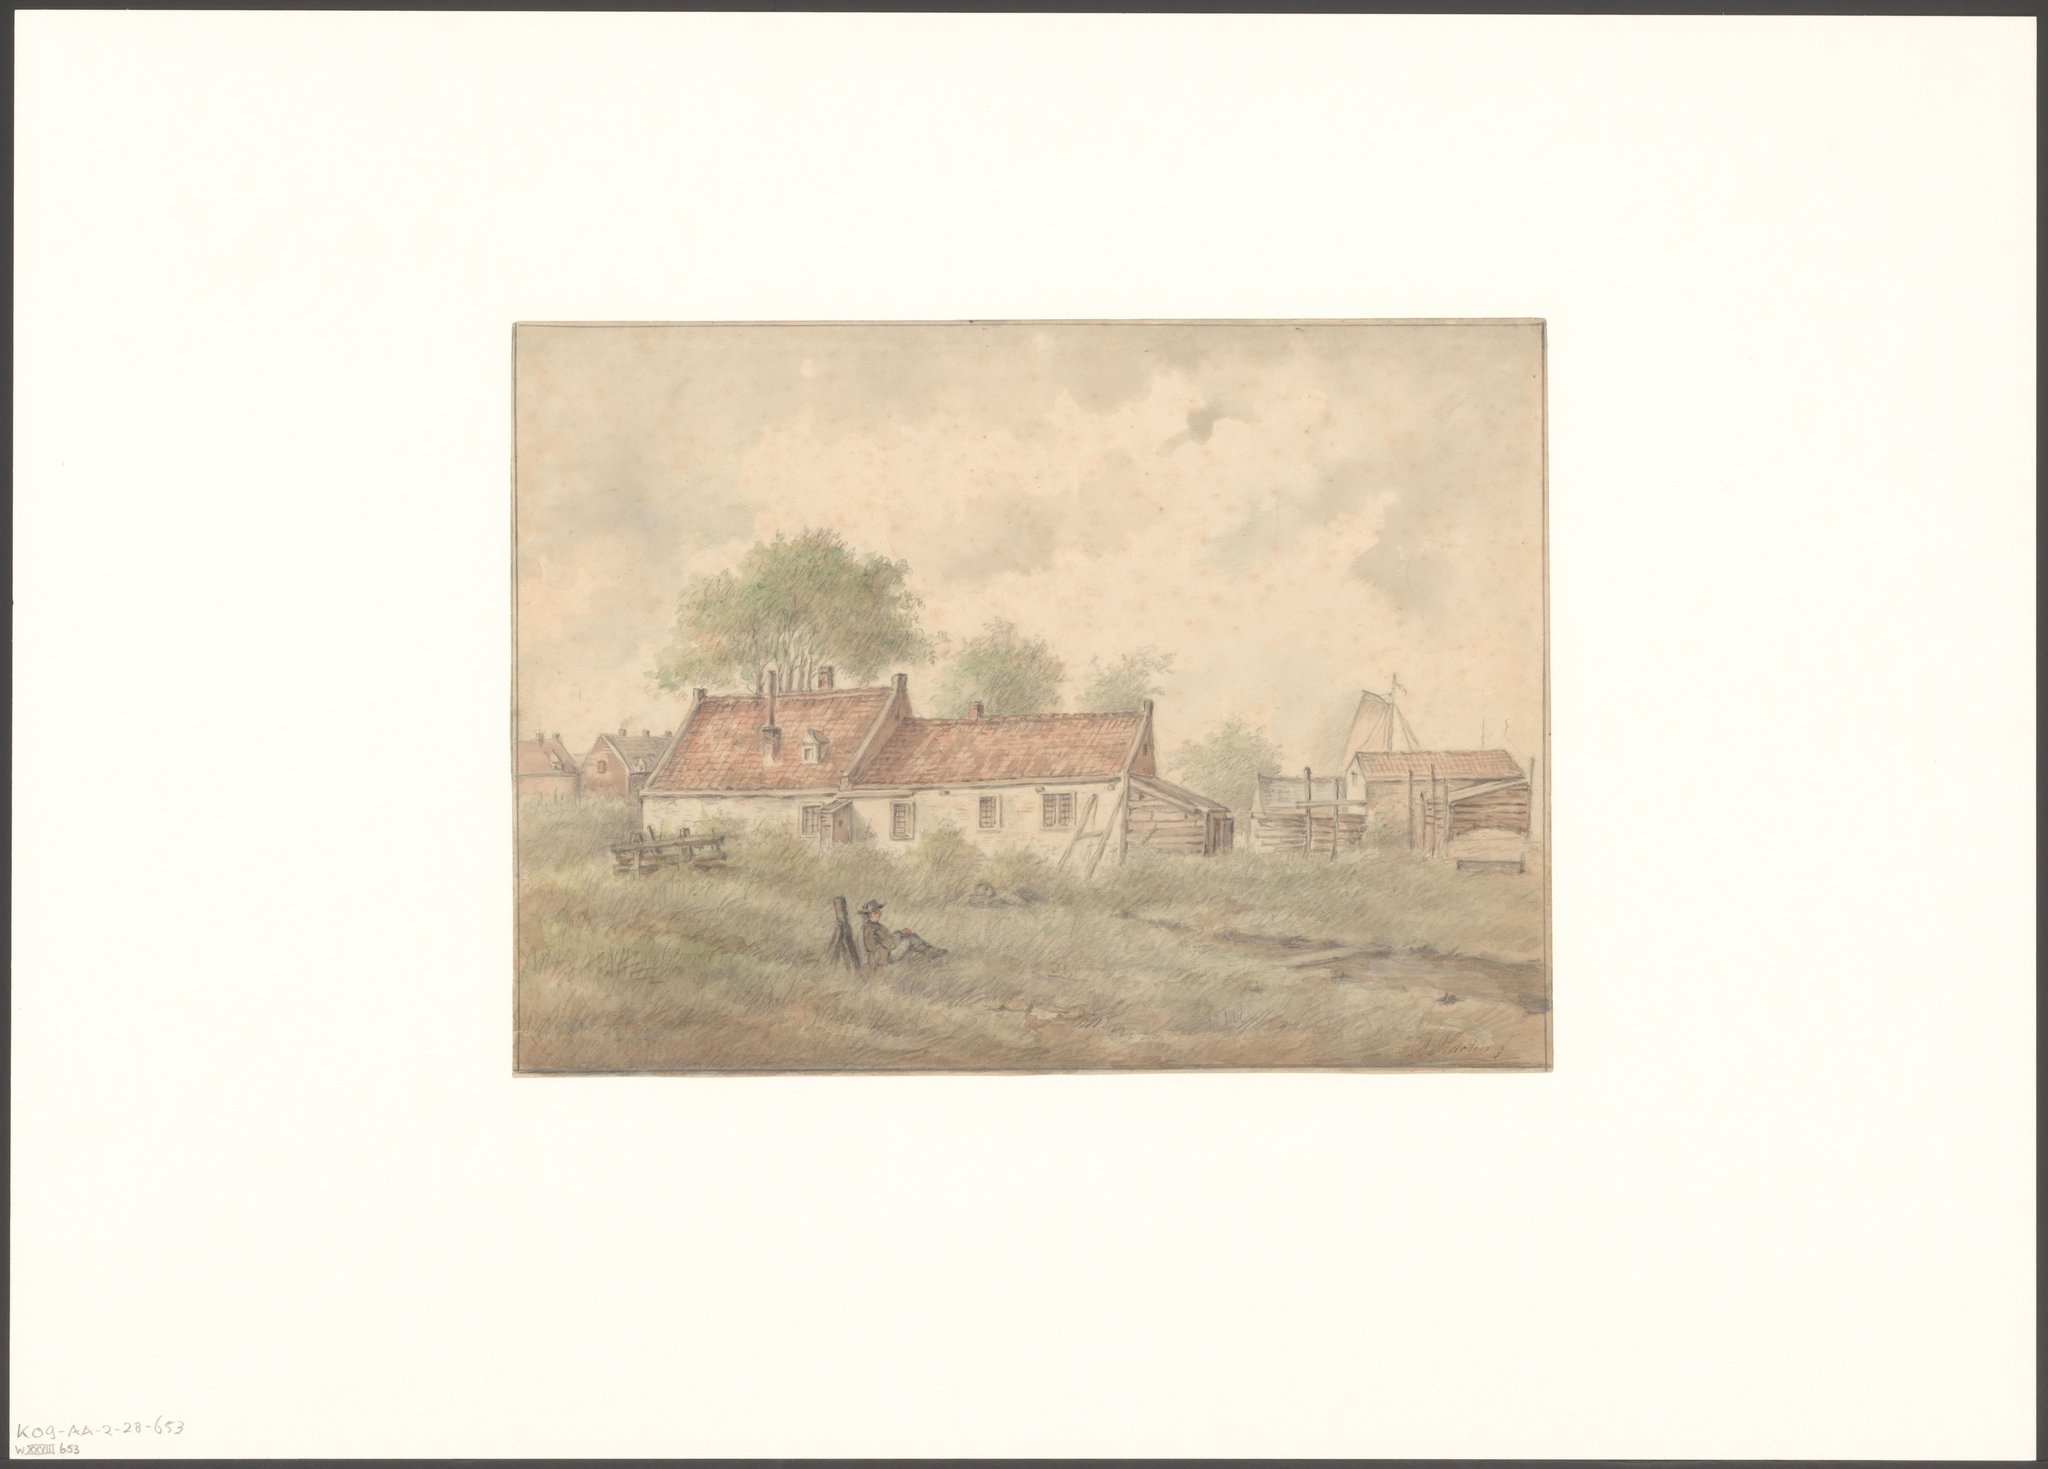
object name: drawing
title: Gezicht op achterzijde van de tweede Vinkenbuurt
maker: albert martin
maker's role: draughtsman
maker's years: 1827-1900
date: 1837-1900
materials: paper, pencil, watercolor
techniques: brush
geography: amsterdam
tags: sailing-ship, sailing-boat, city-view in general; 'veduta', farm or solitary house in landscape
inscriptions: inscription: ‘Achterzijde van de 2 vinkenbuurt’, signature: ‘A.Martin f’, collector's mark: Lugt 800a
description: Tekening binnen de Atlas Van Eck ingedeeld op wijknummer 28.